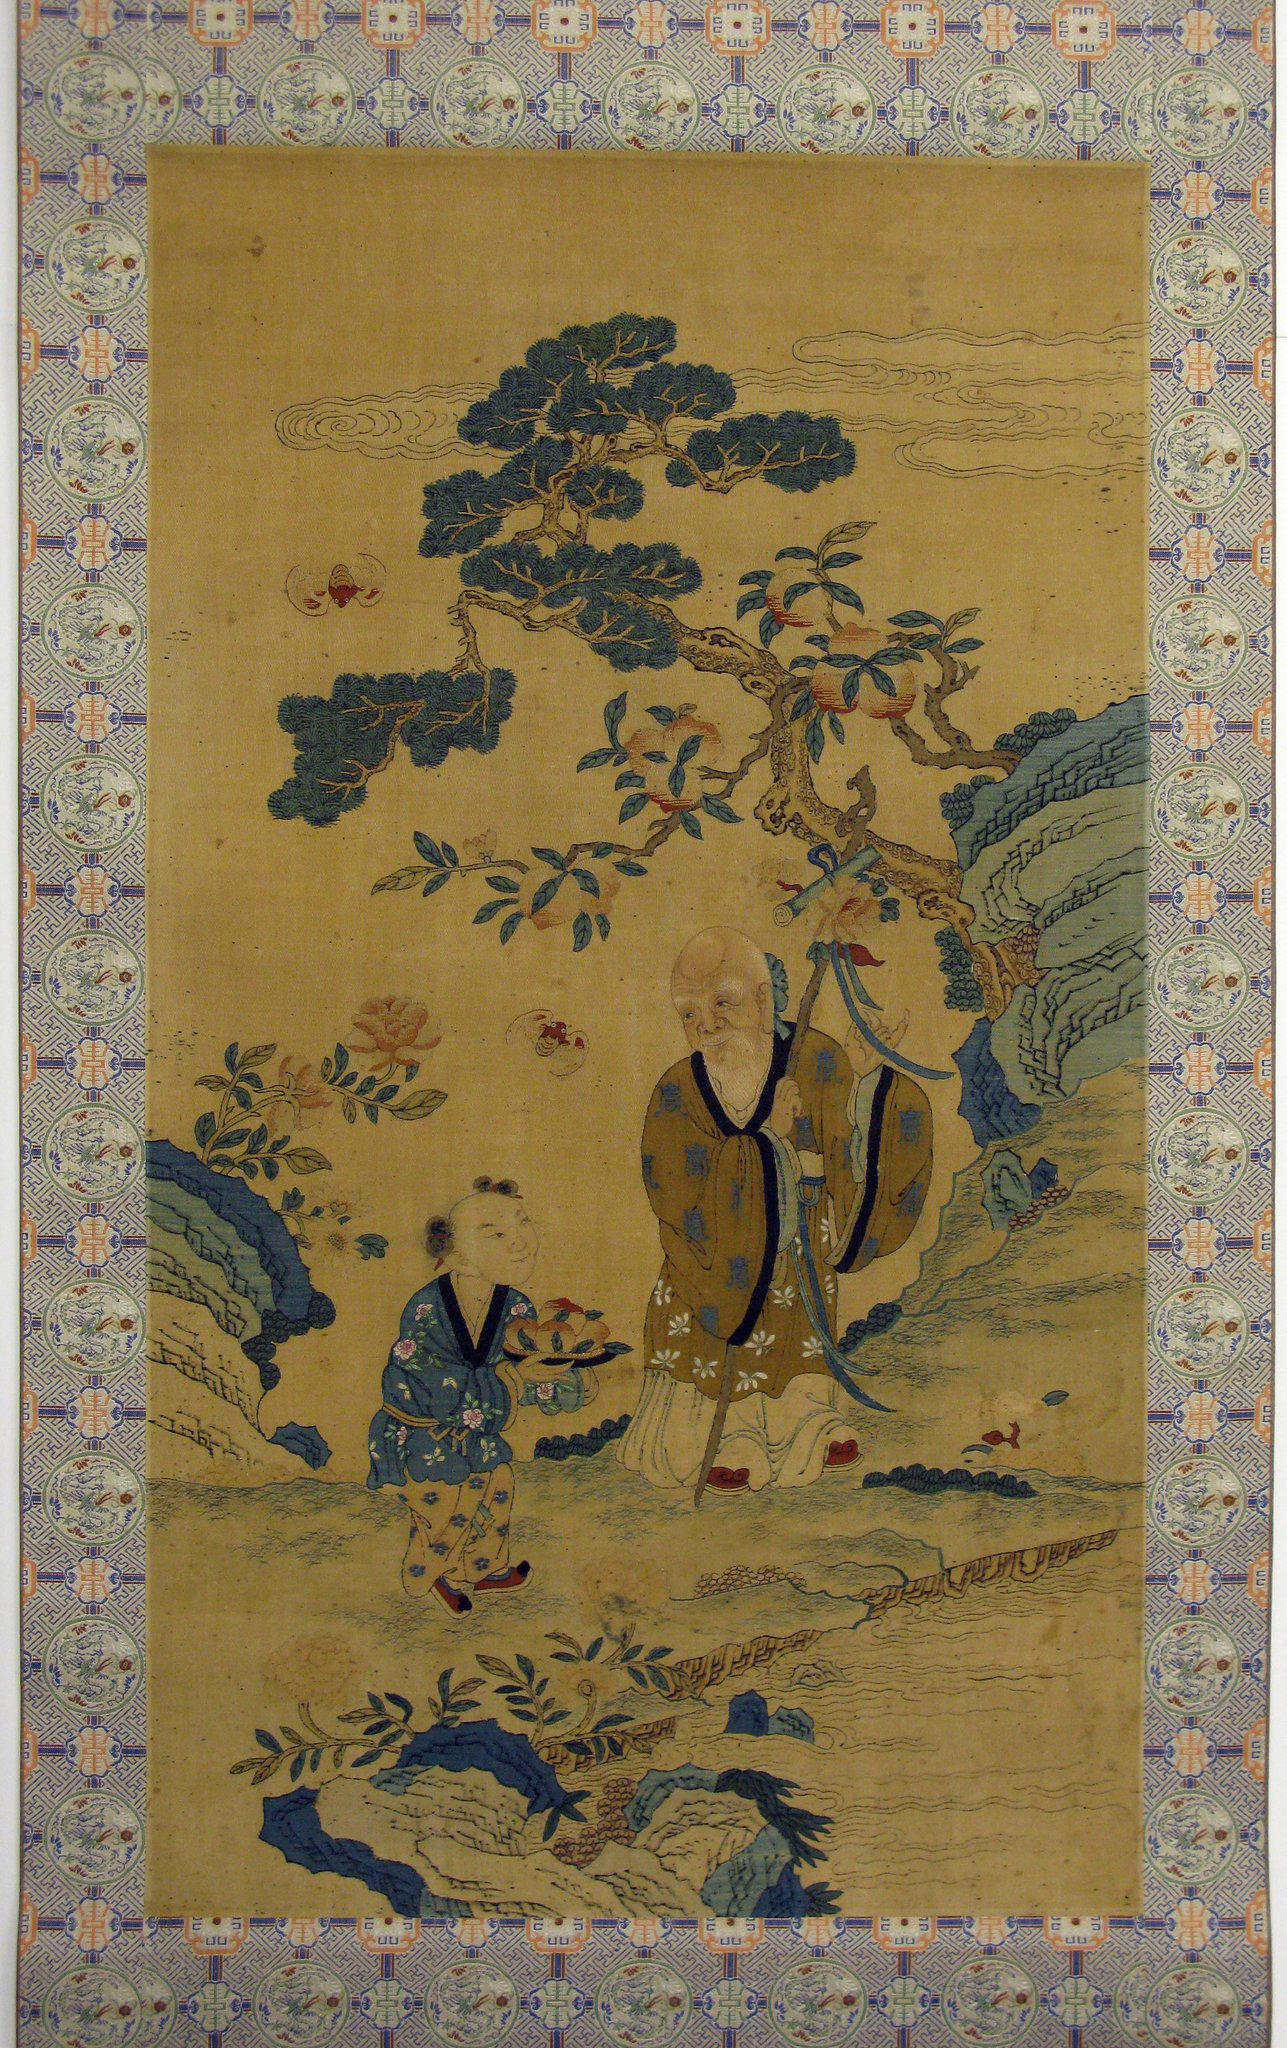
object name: hanging scroll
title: God of Longevity (Shoulao) and boy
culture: chinese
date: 1801-1900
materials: ink, silk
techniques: tapestry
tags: boys,men,trees